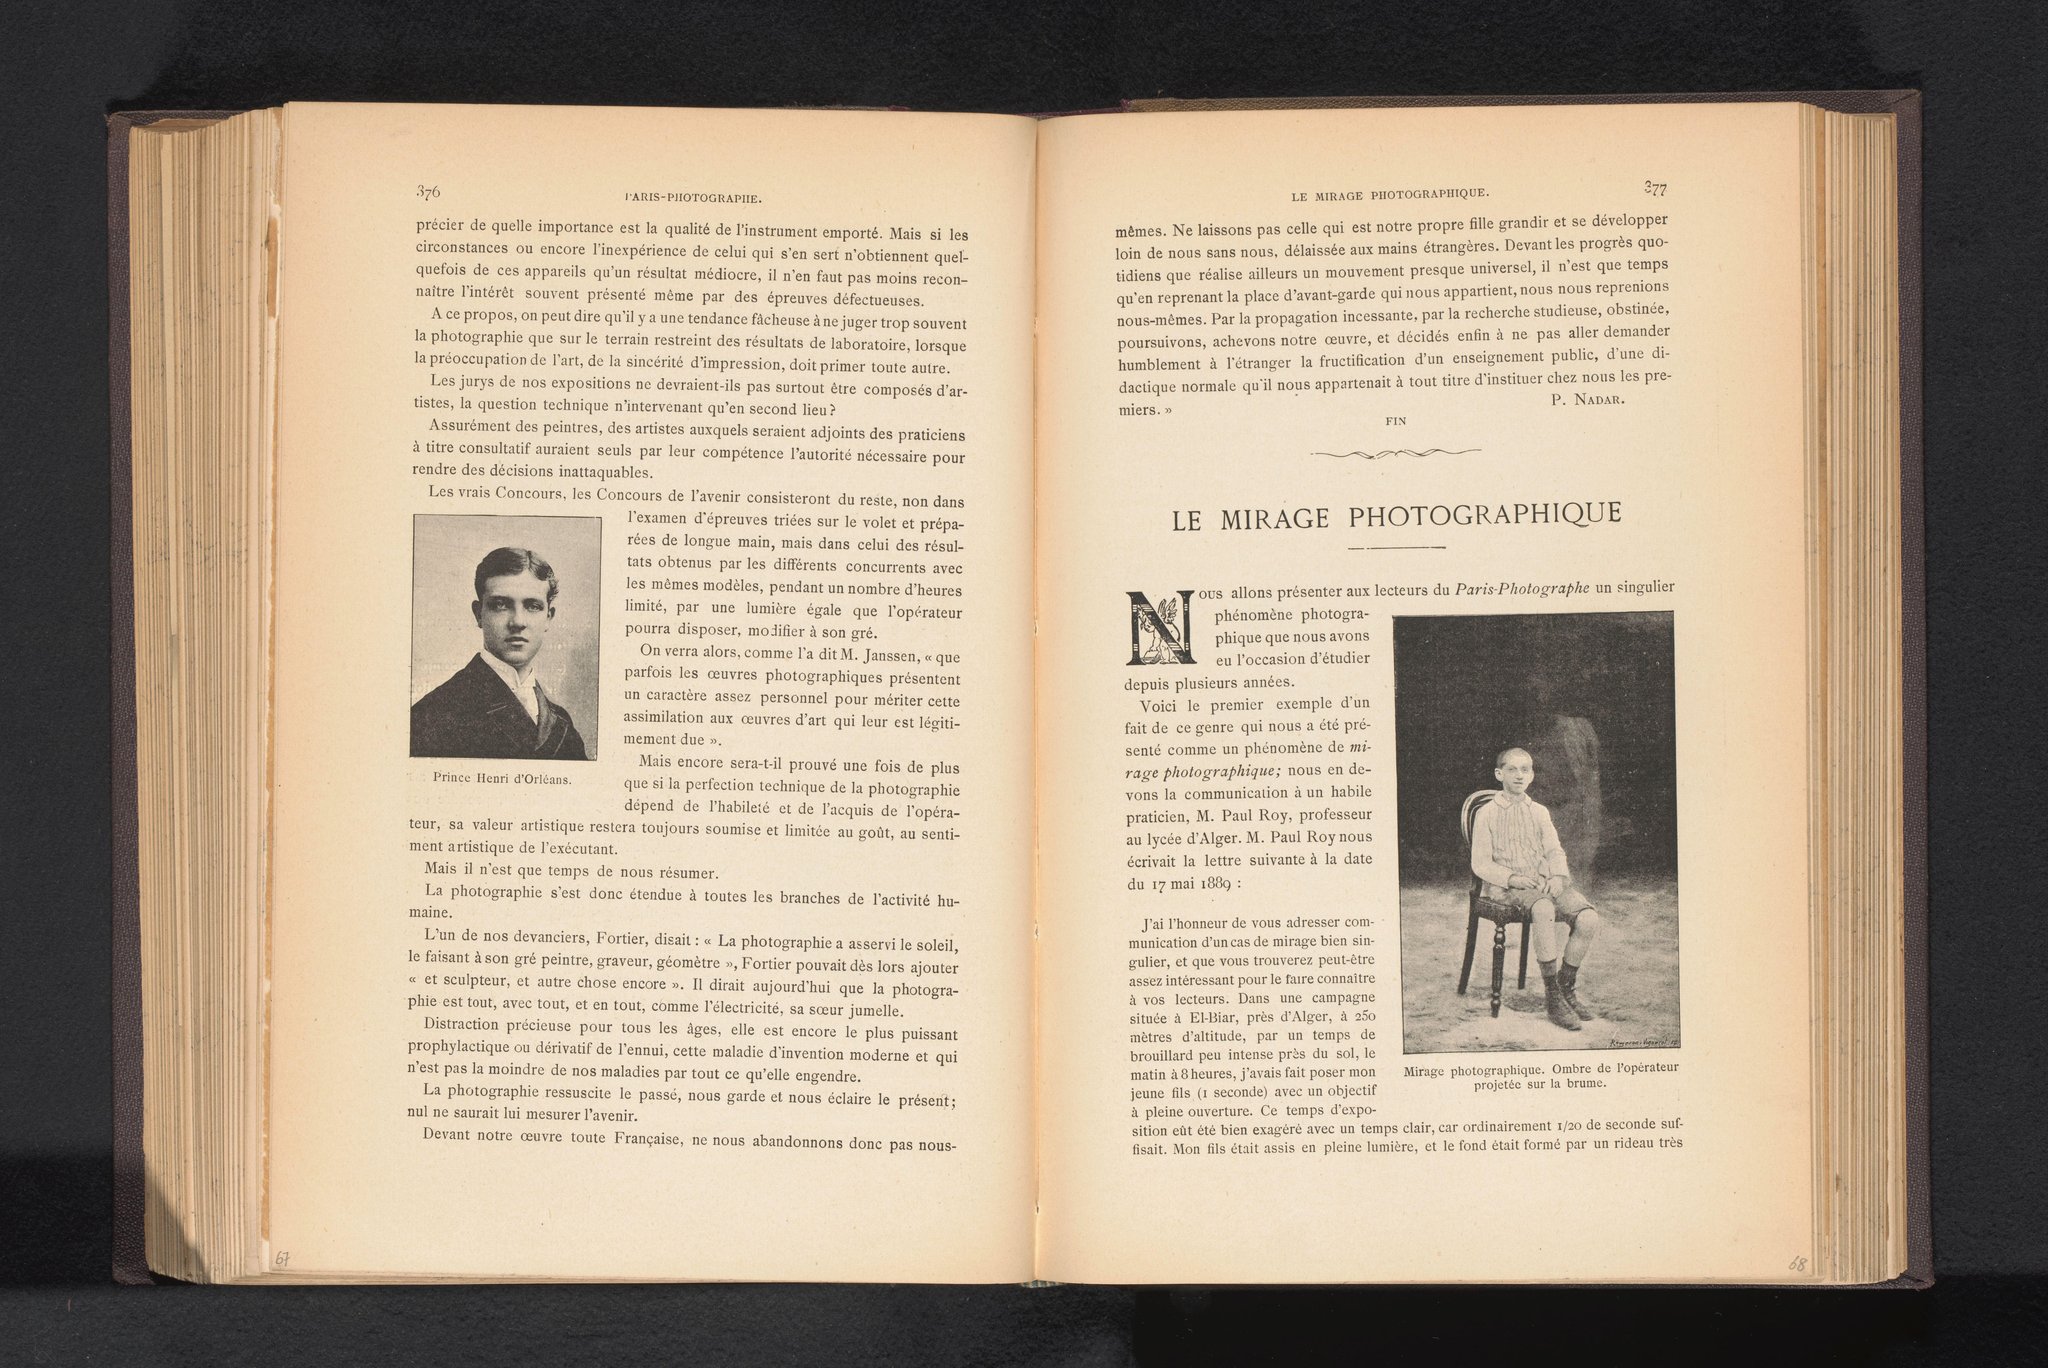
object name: photomechanical print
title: Mirage photographique. Ombre de l'opérateur proketéc sur la brume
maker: Anonymous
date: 1882-1892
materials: paper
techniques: autotype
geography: france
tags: photographer at work